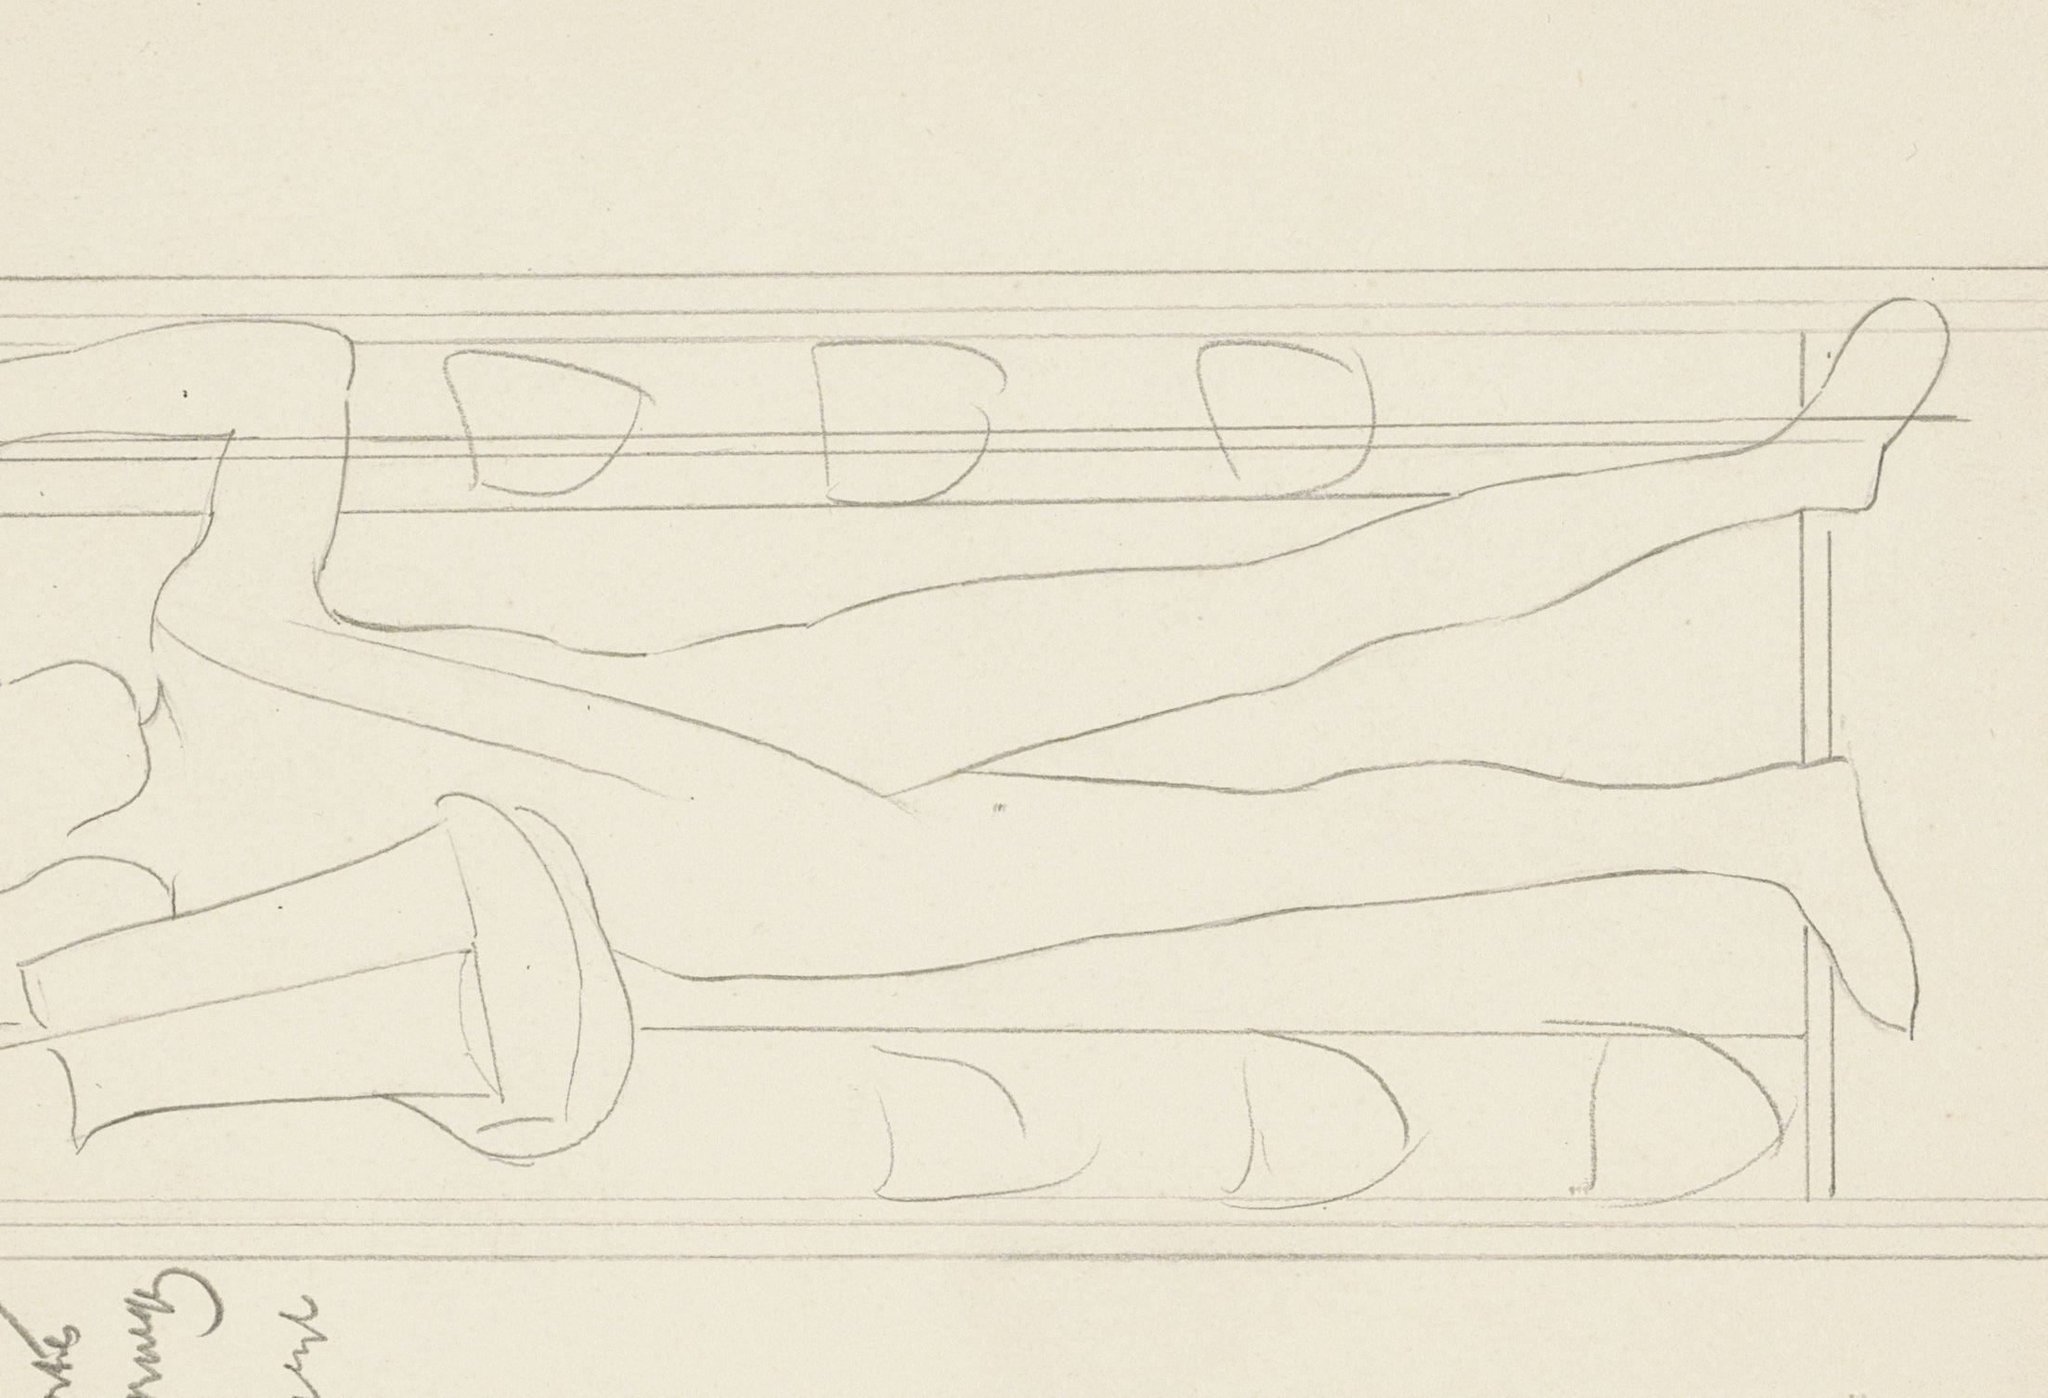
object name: sketchbook leaf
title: Ontwerp voor een venster met personificatie van de Noordzee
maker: antoon derkinderen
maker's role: draughtsman, painter, print maker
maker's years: 1859-1925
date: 1900-1903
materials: paper, pencil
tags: sea personified; 'mare' (ripa), attributes of neptune: trident, ship-model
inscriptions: annotation: ‘Noordzee/ Engeland/ Belgie/ Denemarken/ Zwed/Noorwegen/ [...]’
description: De zeegod staat met een scheepsmodel onder zijn arm en drietand in de hand. Ontwerp voor een glas-in-loodraam voor de Kamer van Koophandel in de Beurs van Berlage te Amsterdam. Blad 32 recto uit een schetsboek met 45 bladen.